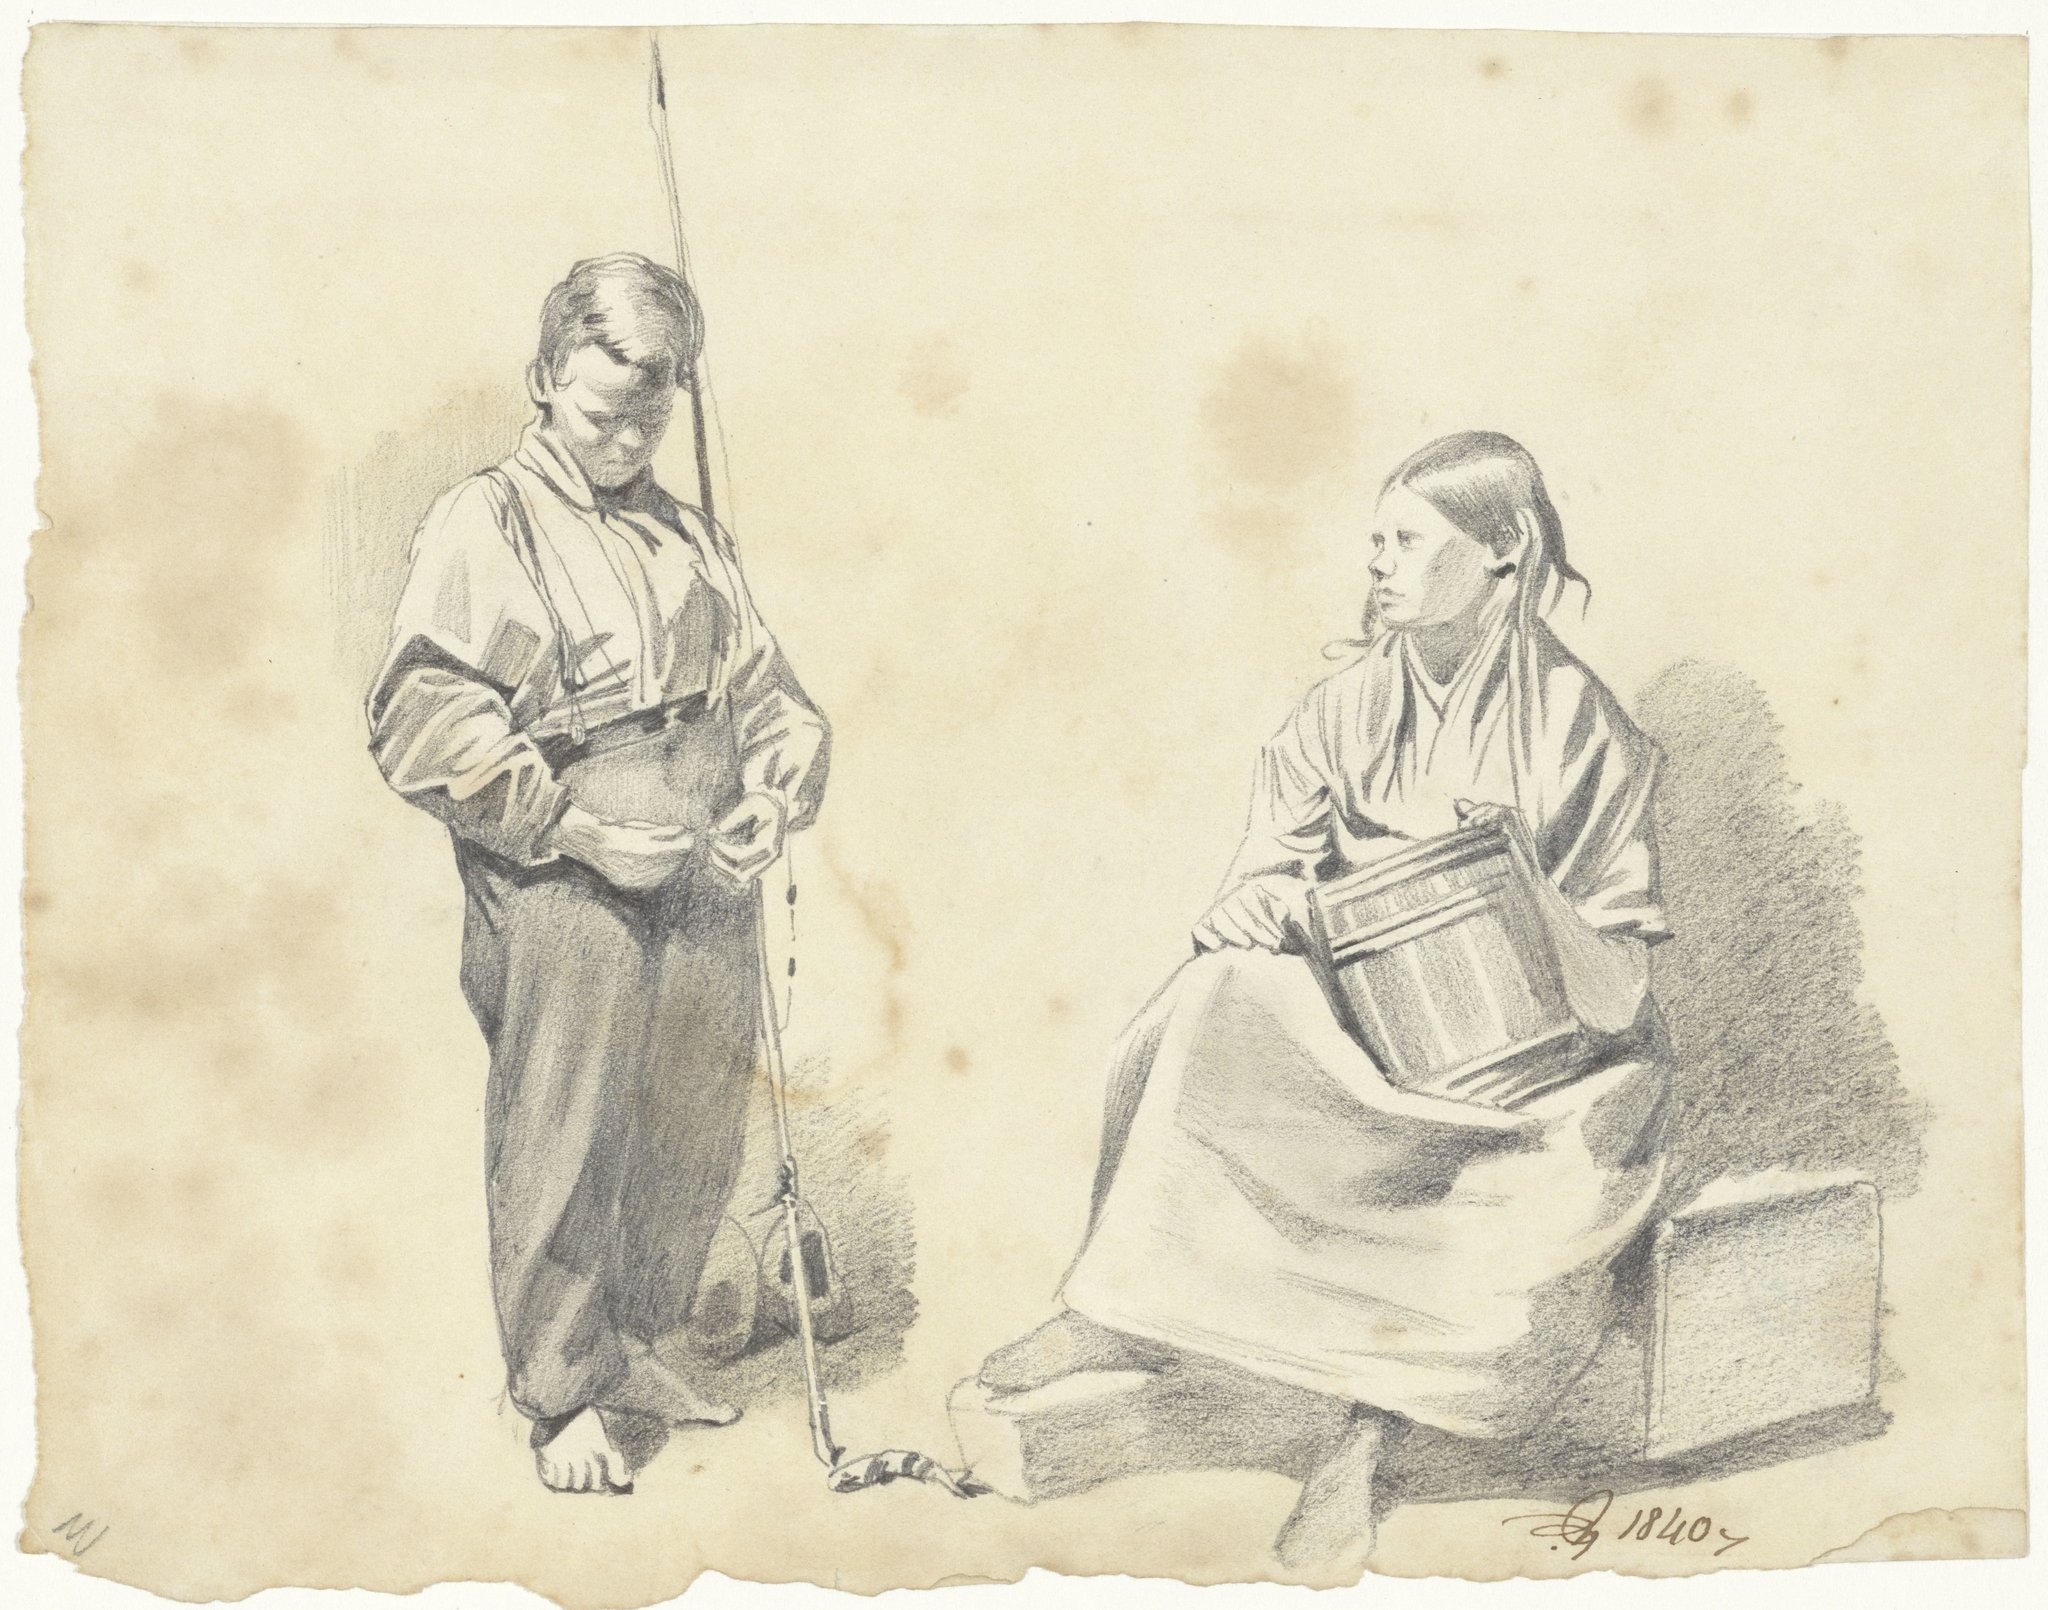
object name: drawing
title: Staande jongen met hengel en zittende vrouw met tonnetje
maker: pieter van loon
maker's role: draughtsman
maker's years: 1801-1873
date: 1840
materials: paper, pencil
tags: angling